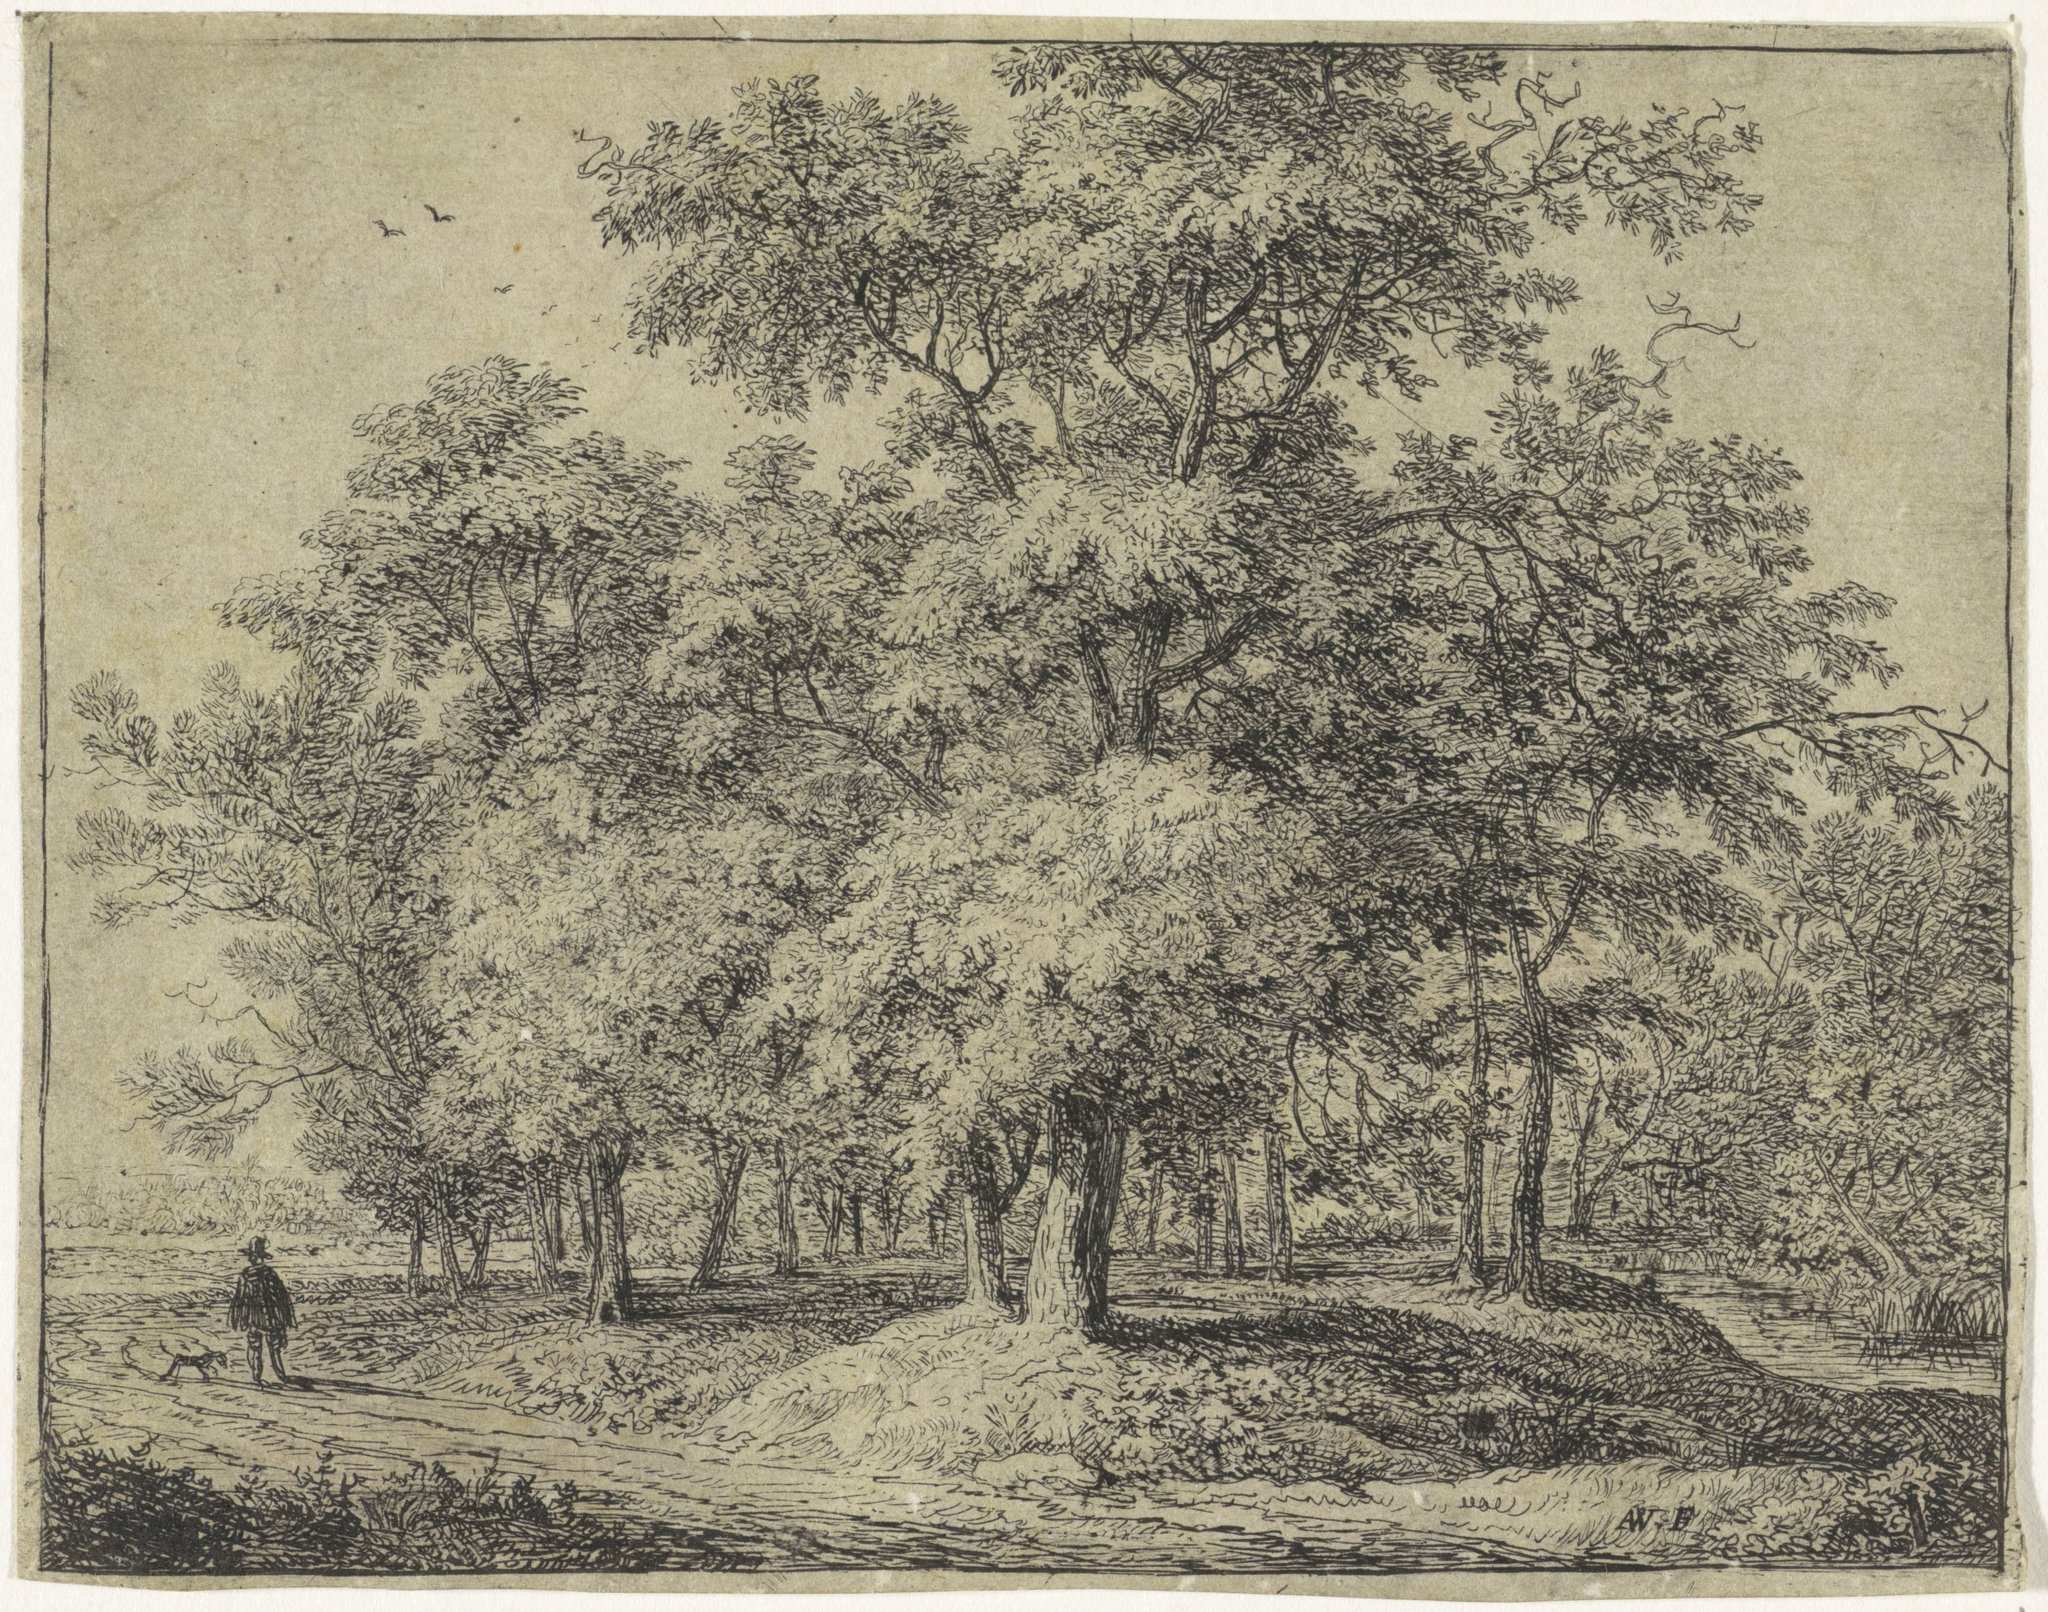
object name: print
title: Man met hond in een bos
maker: anthonie waterloo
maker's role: draughtsman, painter, print maker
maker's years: 1609-1690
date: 1630-1663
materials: paper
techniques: etching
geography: amsterdam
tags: forest, wood, landscapes (+ landscape with figures, staffage), dog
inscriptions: collector's mark: Lugt 2228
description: Zie Hollstein voor een volledig overzicht van de verschillende edities.